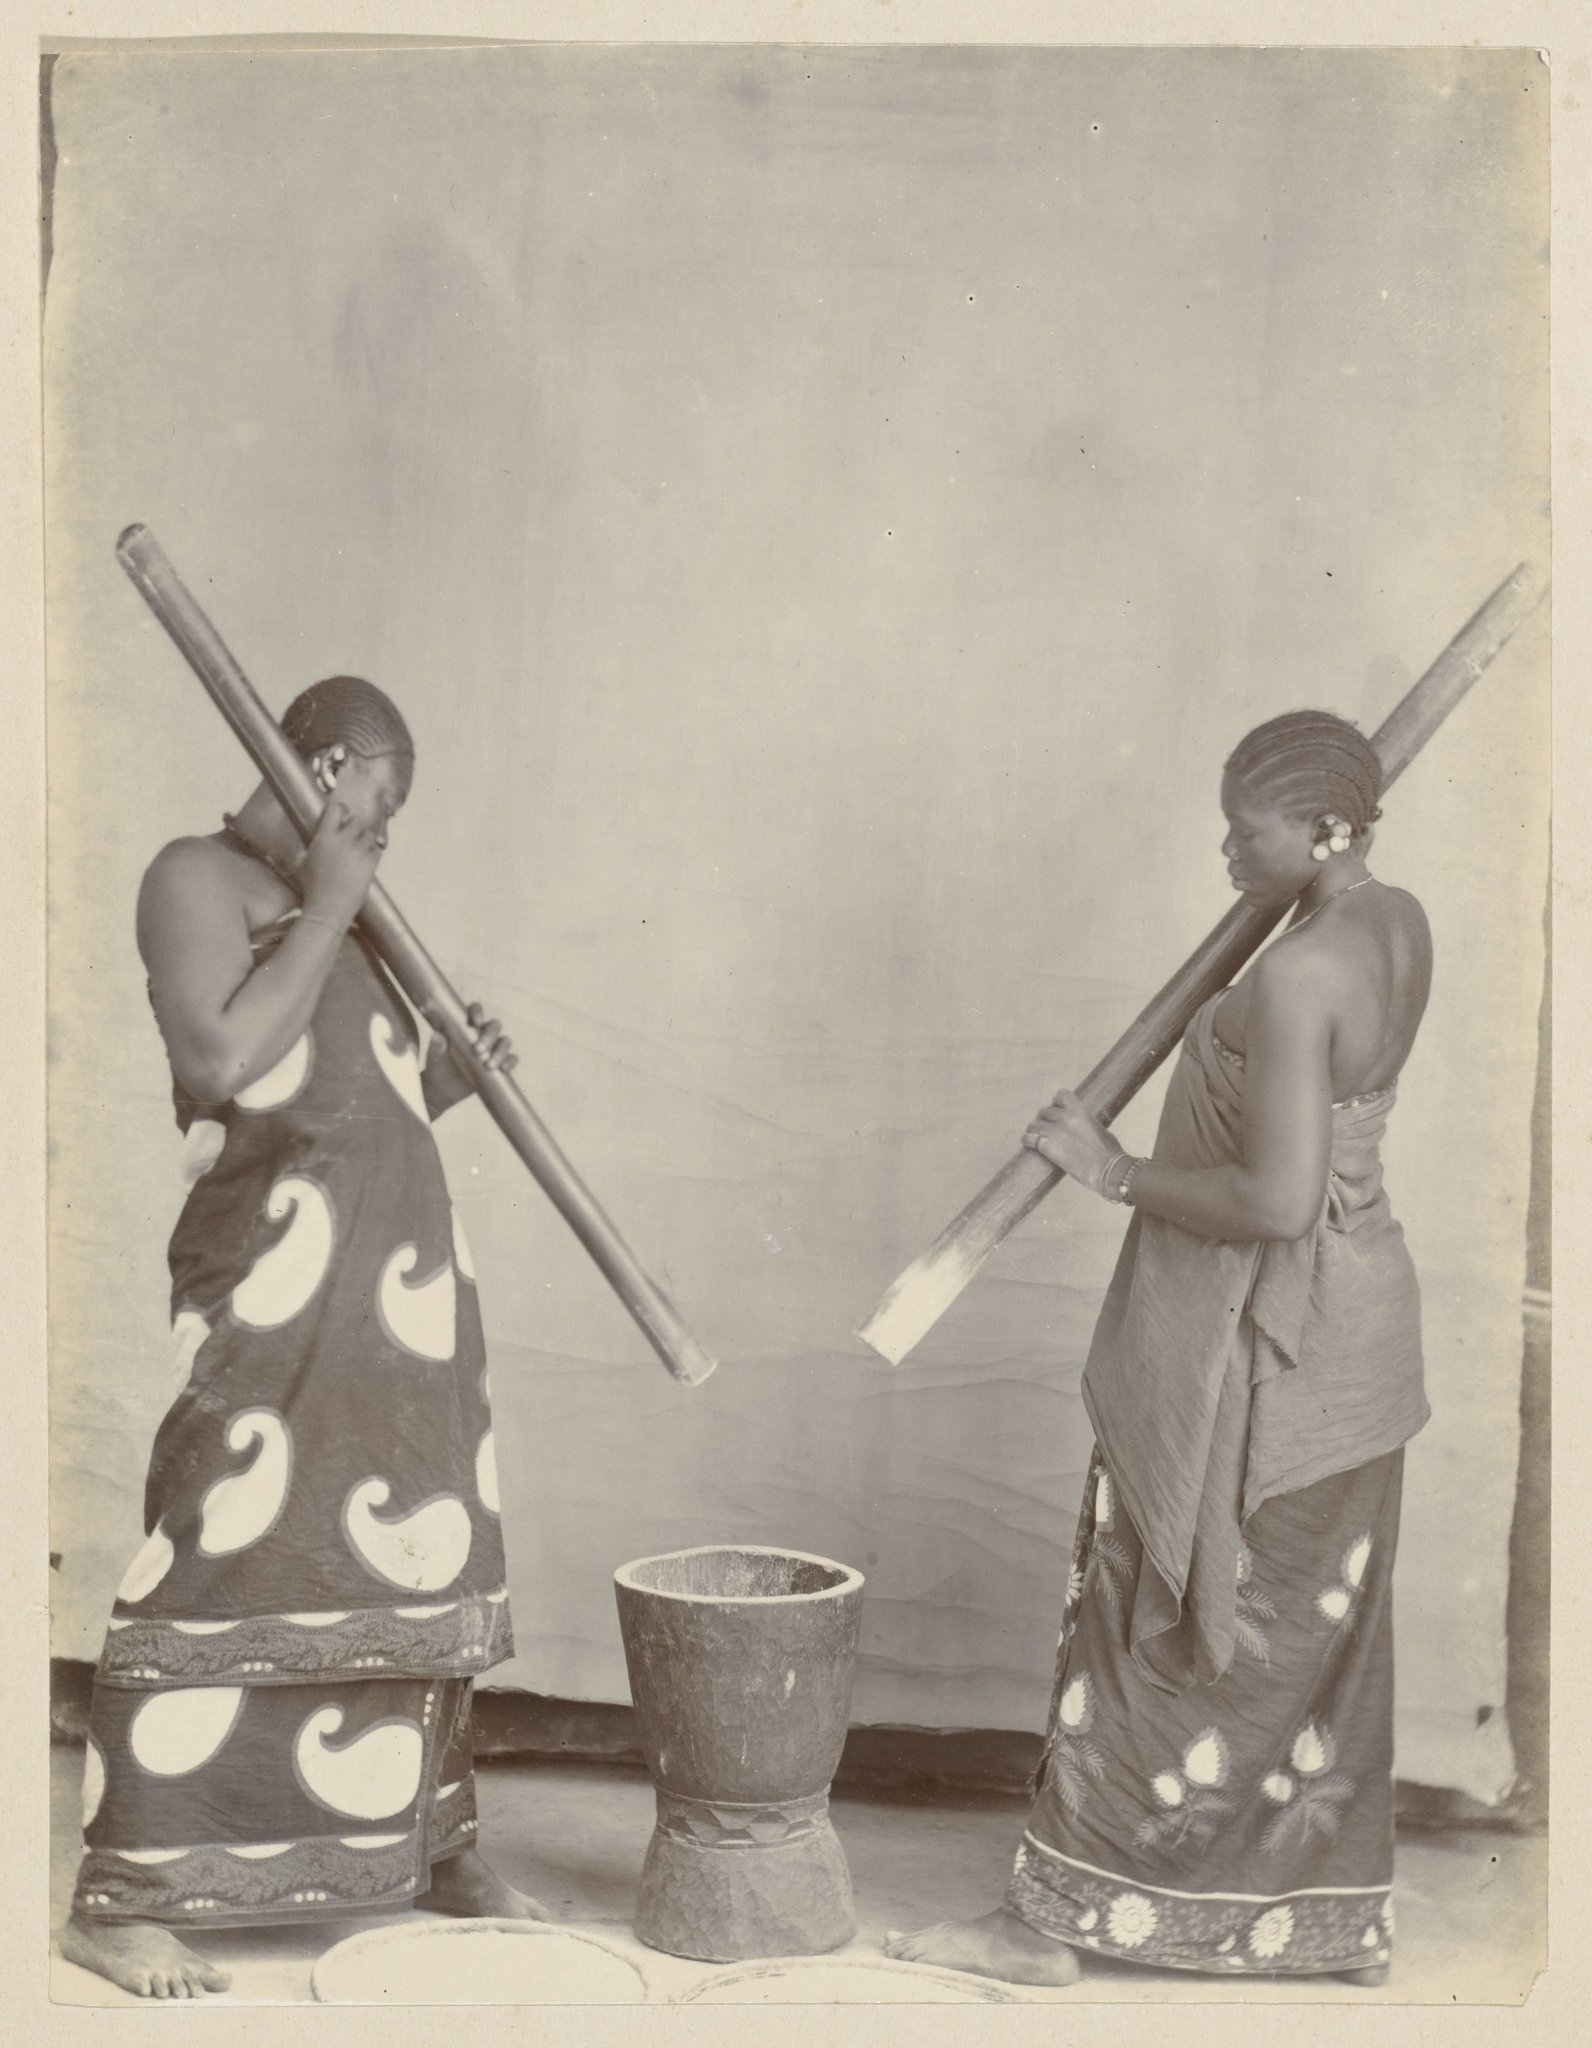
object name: photograph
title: Afrikaanse vrouwen in lange gewaden stampen in vijzel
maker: Anonymous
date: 1890-1910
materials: cardboard, paper, photographic support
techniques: gelatin silver print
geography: africa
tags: furniture and household effects